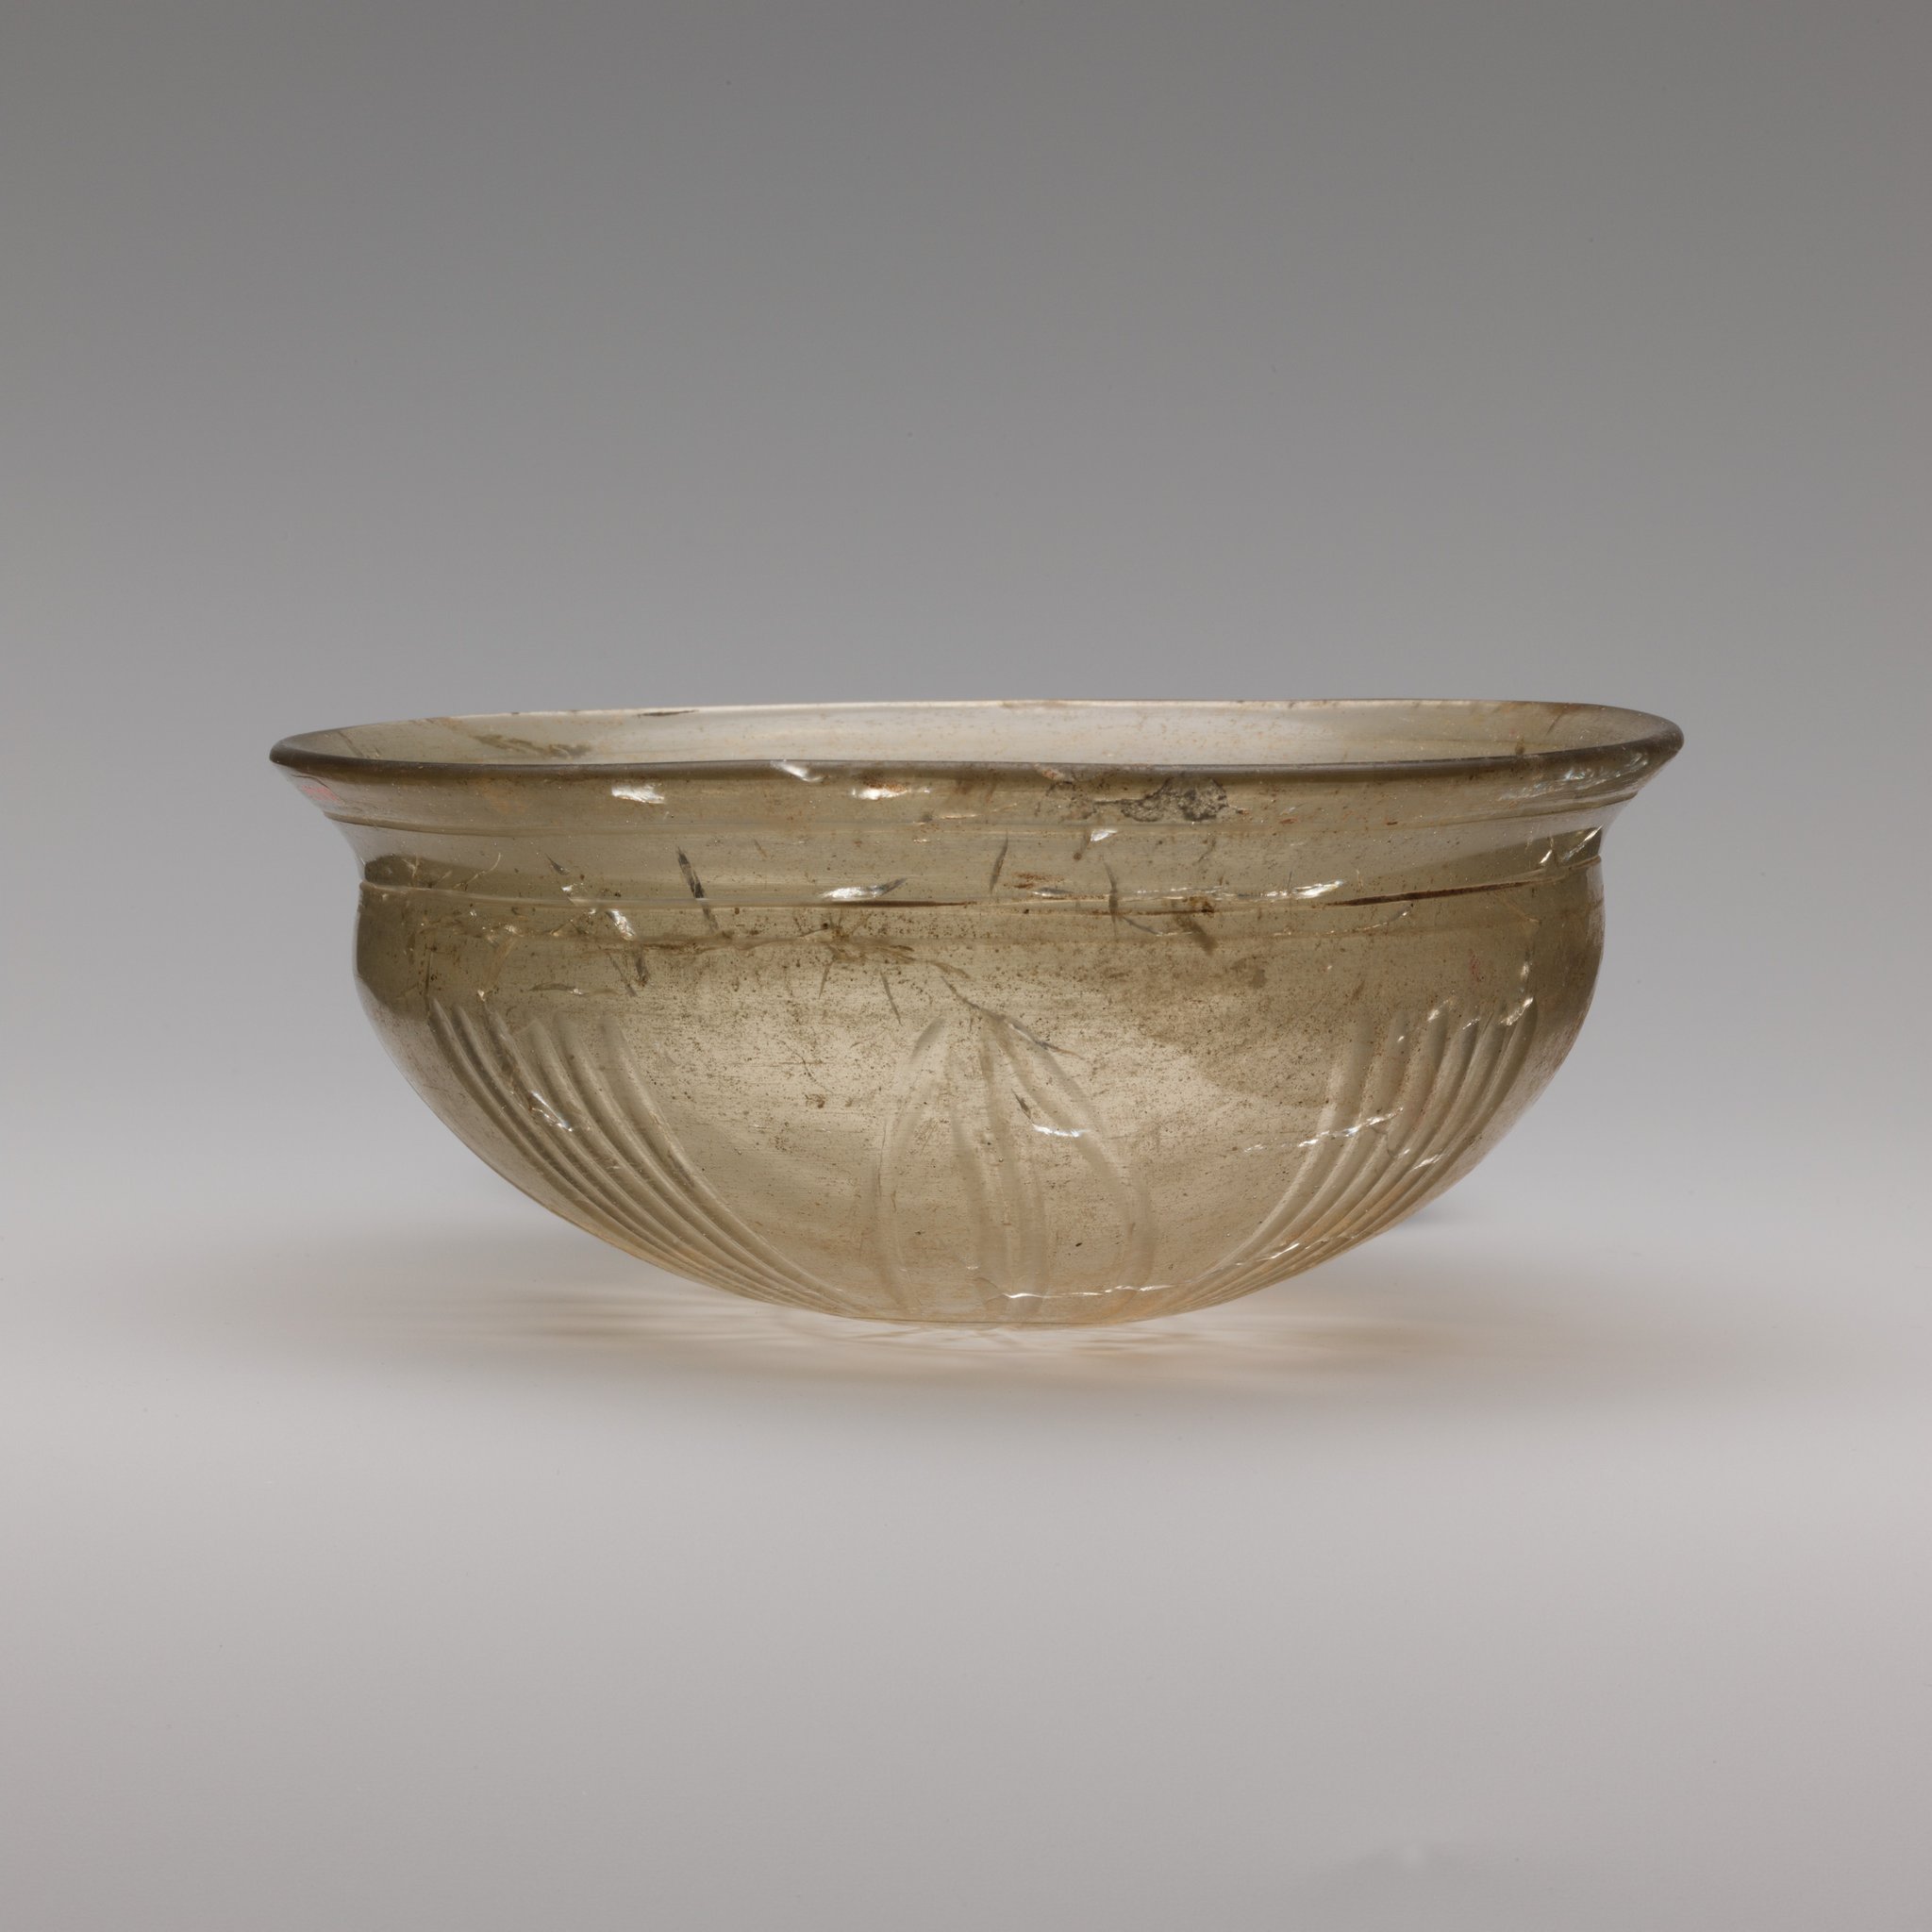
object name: phiale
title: Glass phiale (libation bowl)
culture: greek, eastern mediterranean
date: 334-301 BCE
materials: glass